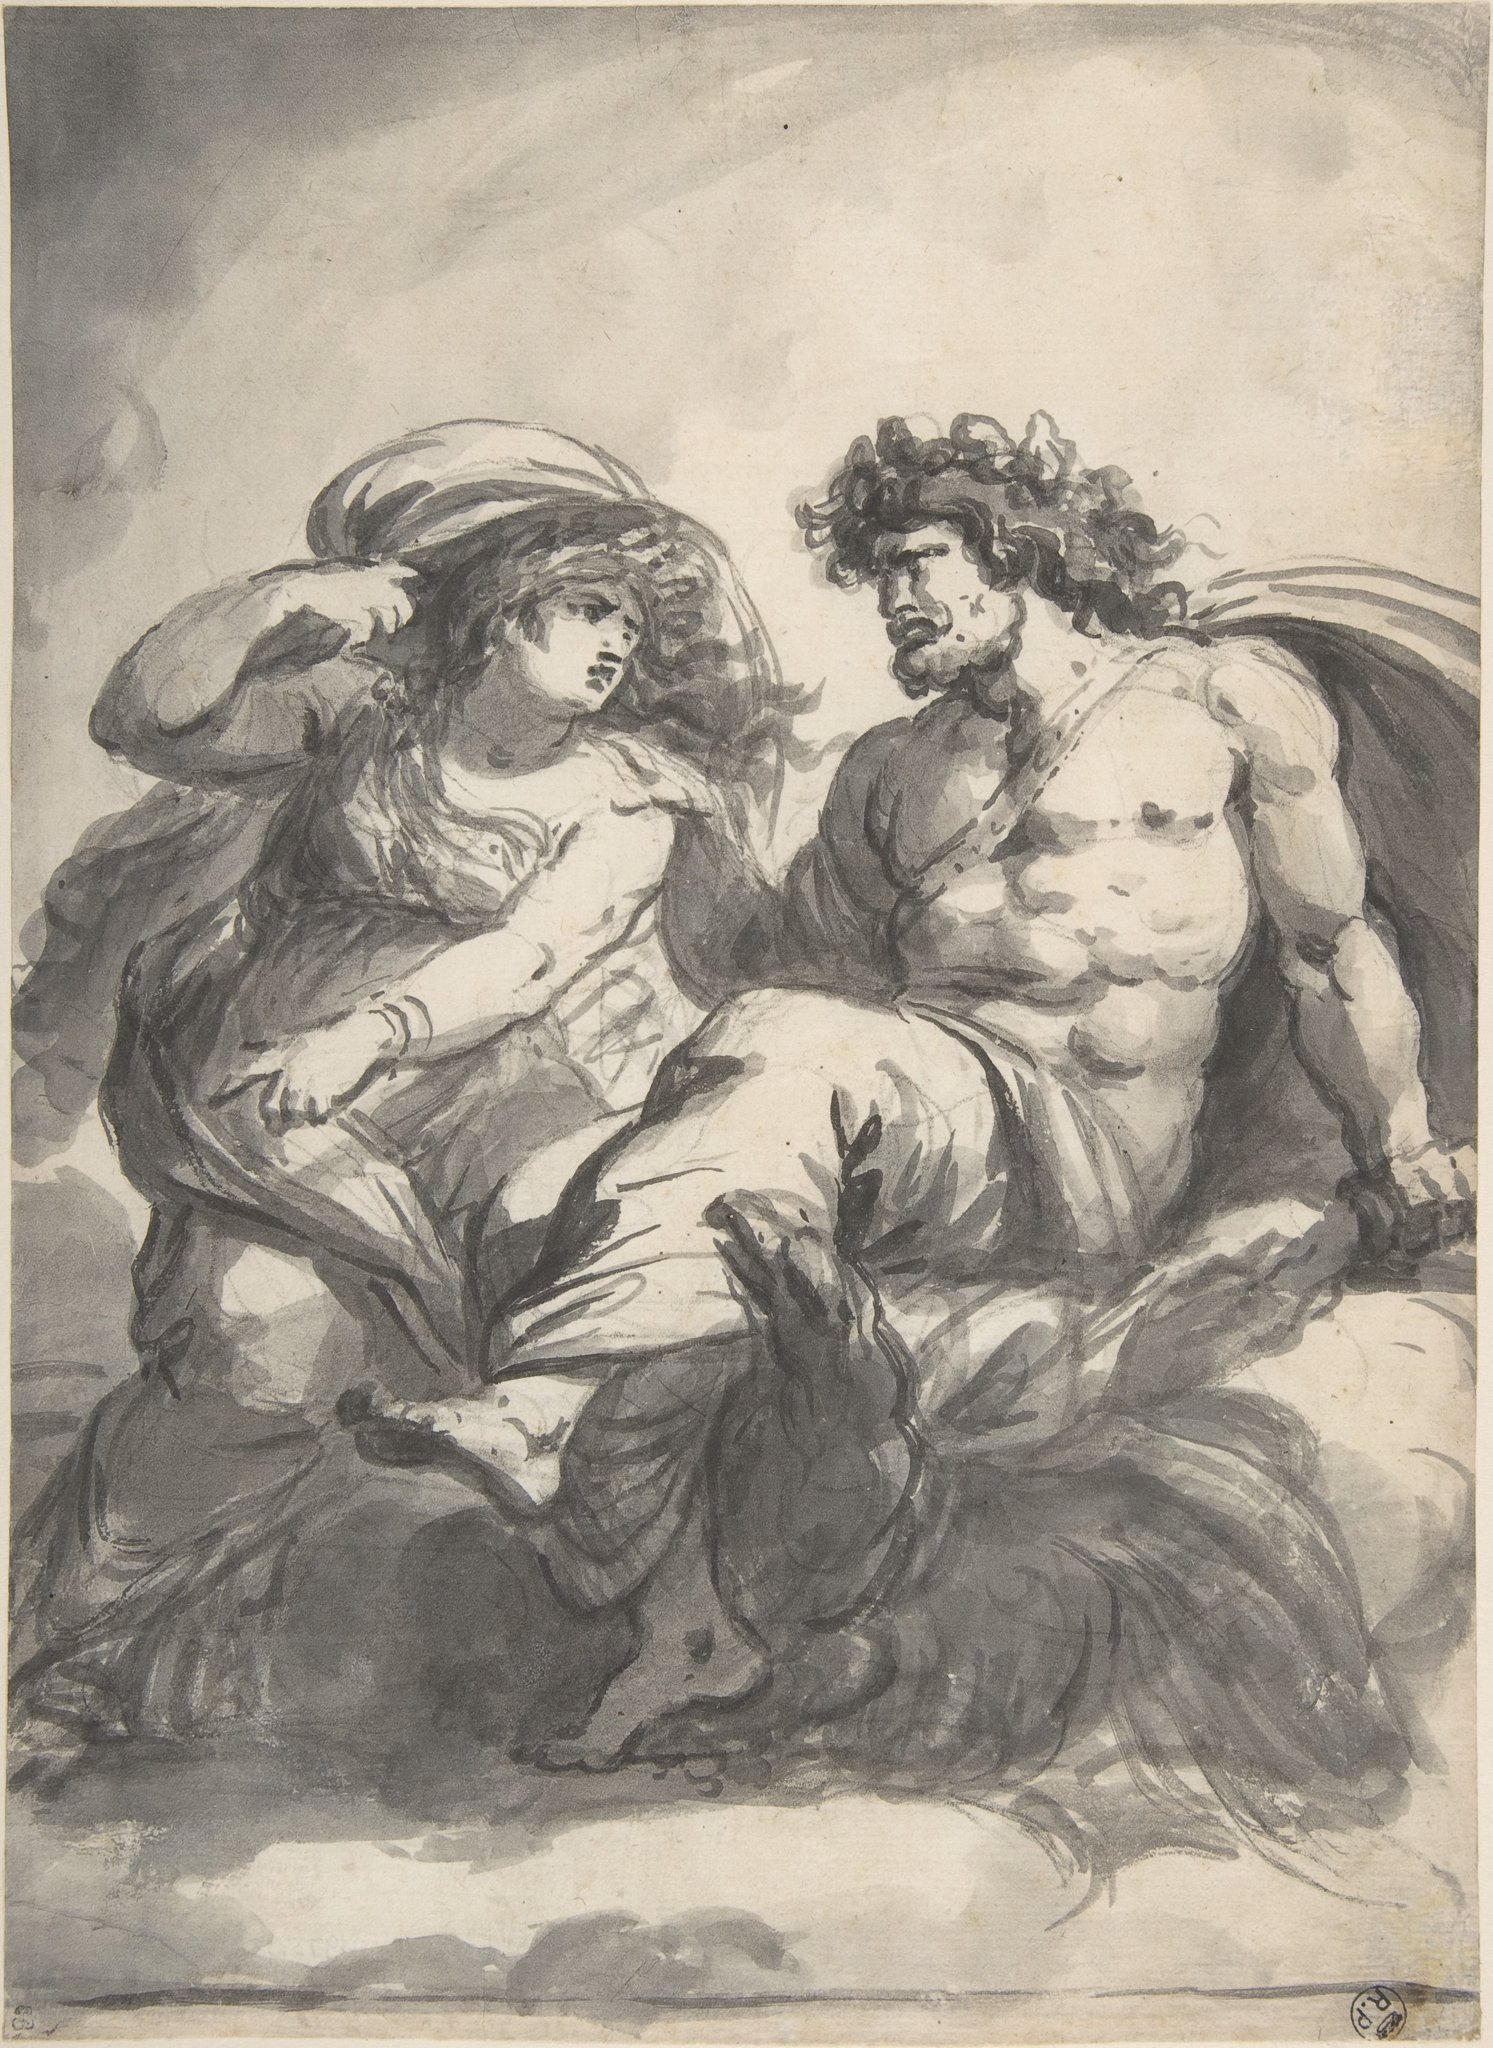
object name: drawing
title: Jupiter and Ceres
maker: antoine françois callet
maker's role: artist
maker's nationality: french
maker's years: 1741-1823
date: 1777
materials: chalk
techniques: brush, wash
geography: france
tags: ceres,jupiter